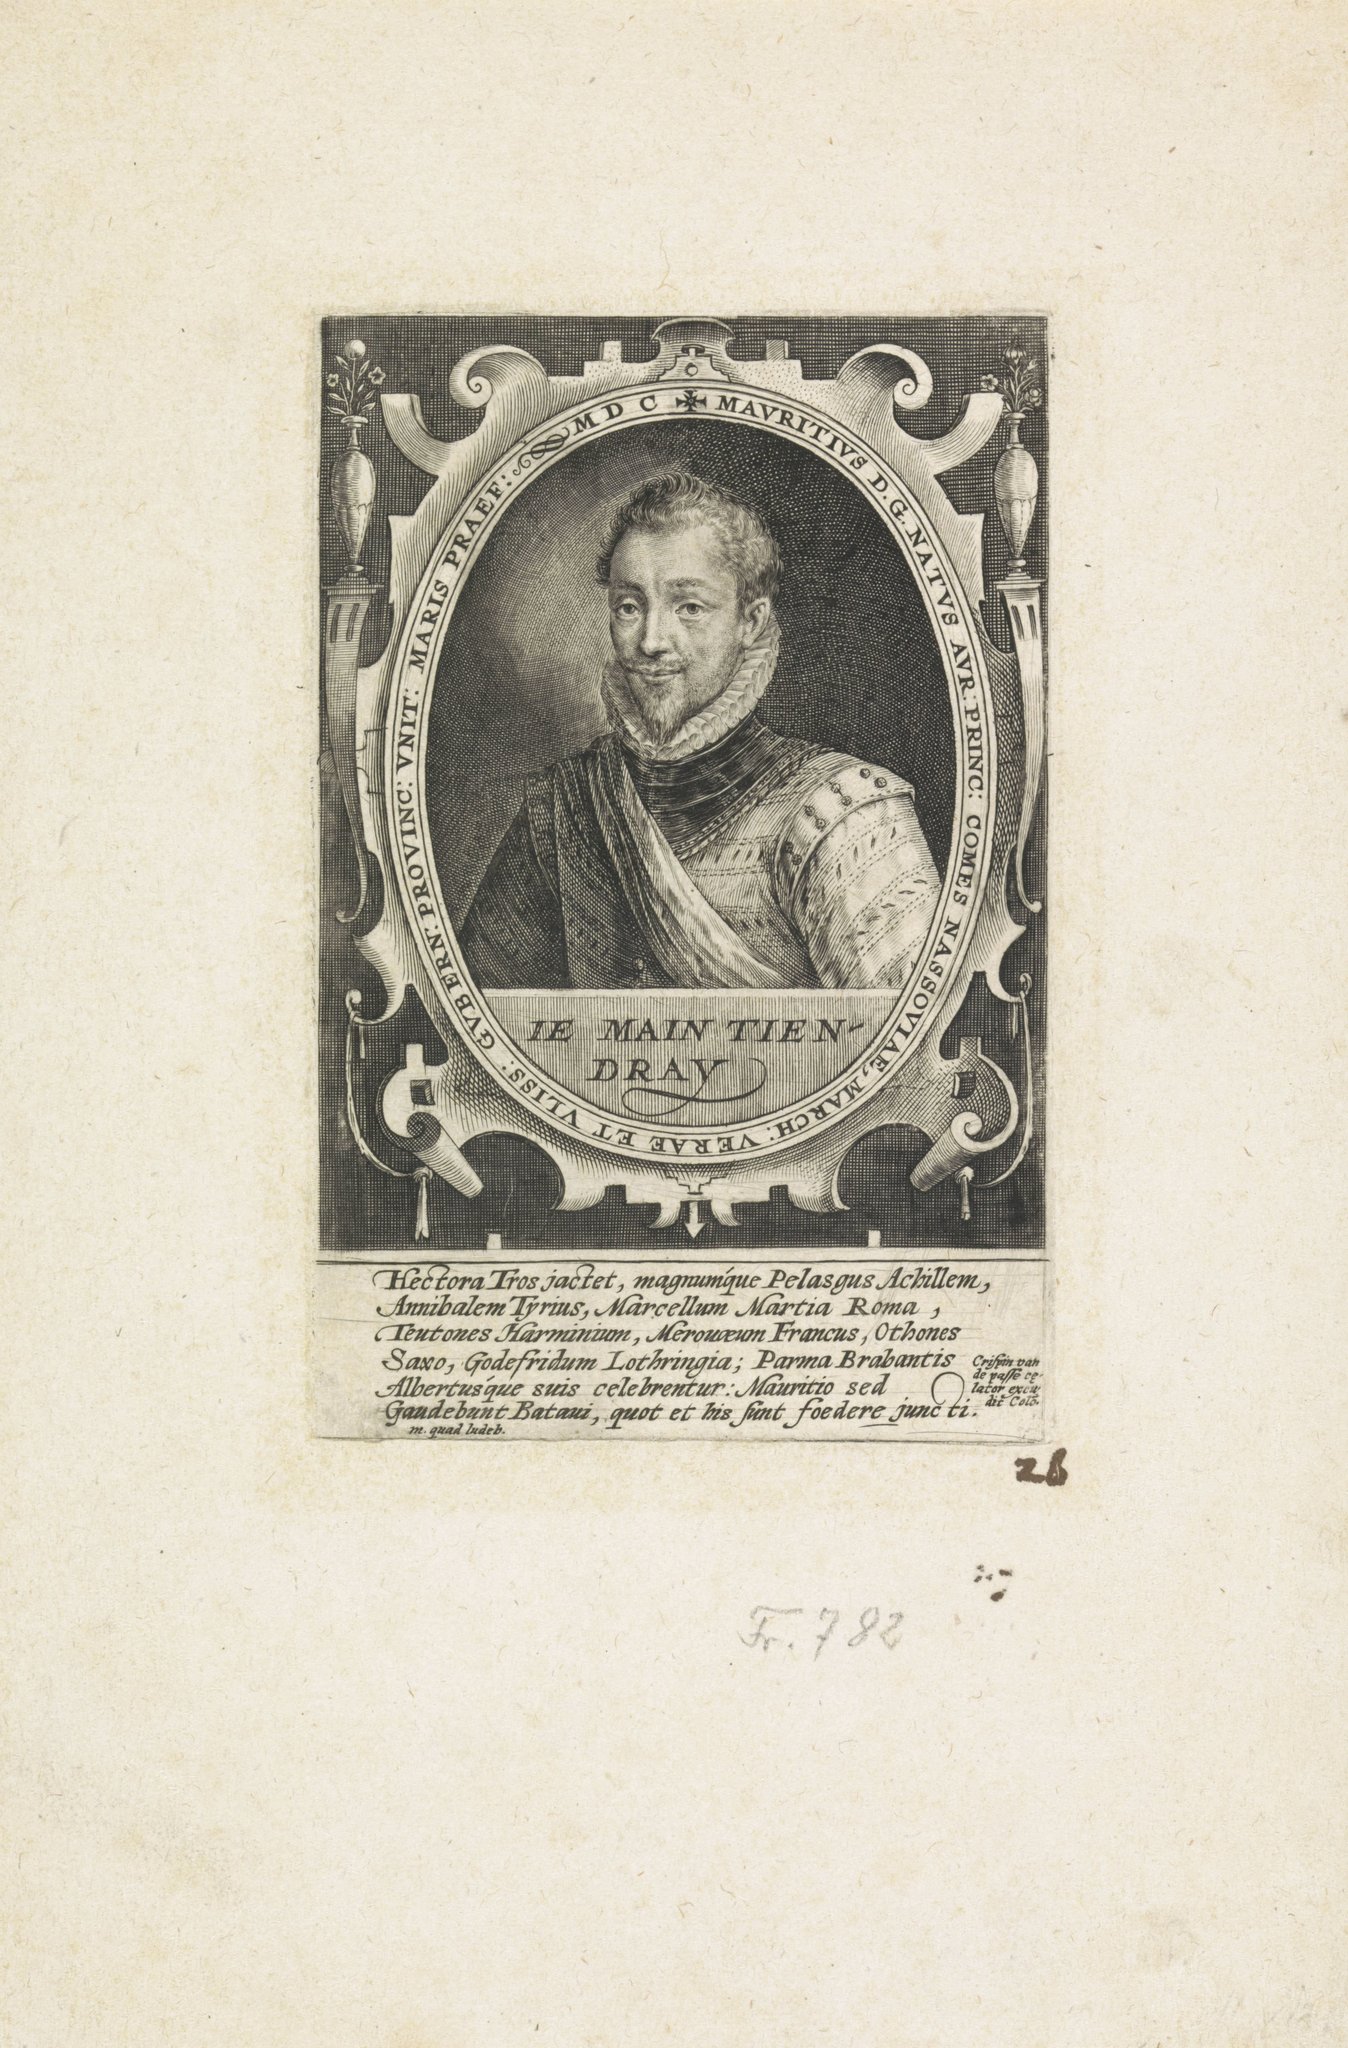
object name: print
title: Portret van Maurits, prins van Oranje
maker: crispijn van de passe (i)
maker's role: draughtsman, print maker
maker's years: 1564-1637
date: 1600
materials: paper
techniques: engraving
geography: cologne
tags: the hague, maurice (prince of orange)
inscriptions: date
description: De hier vermelde titel verwijst naar de hoogst verkregen titel van de geportretteerde, niet per se naar de titel die de geportretteerde op deze voorstelling draagt.